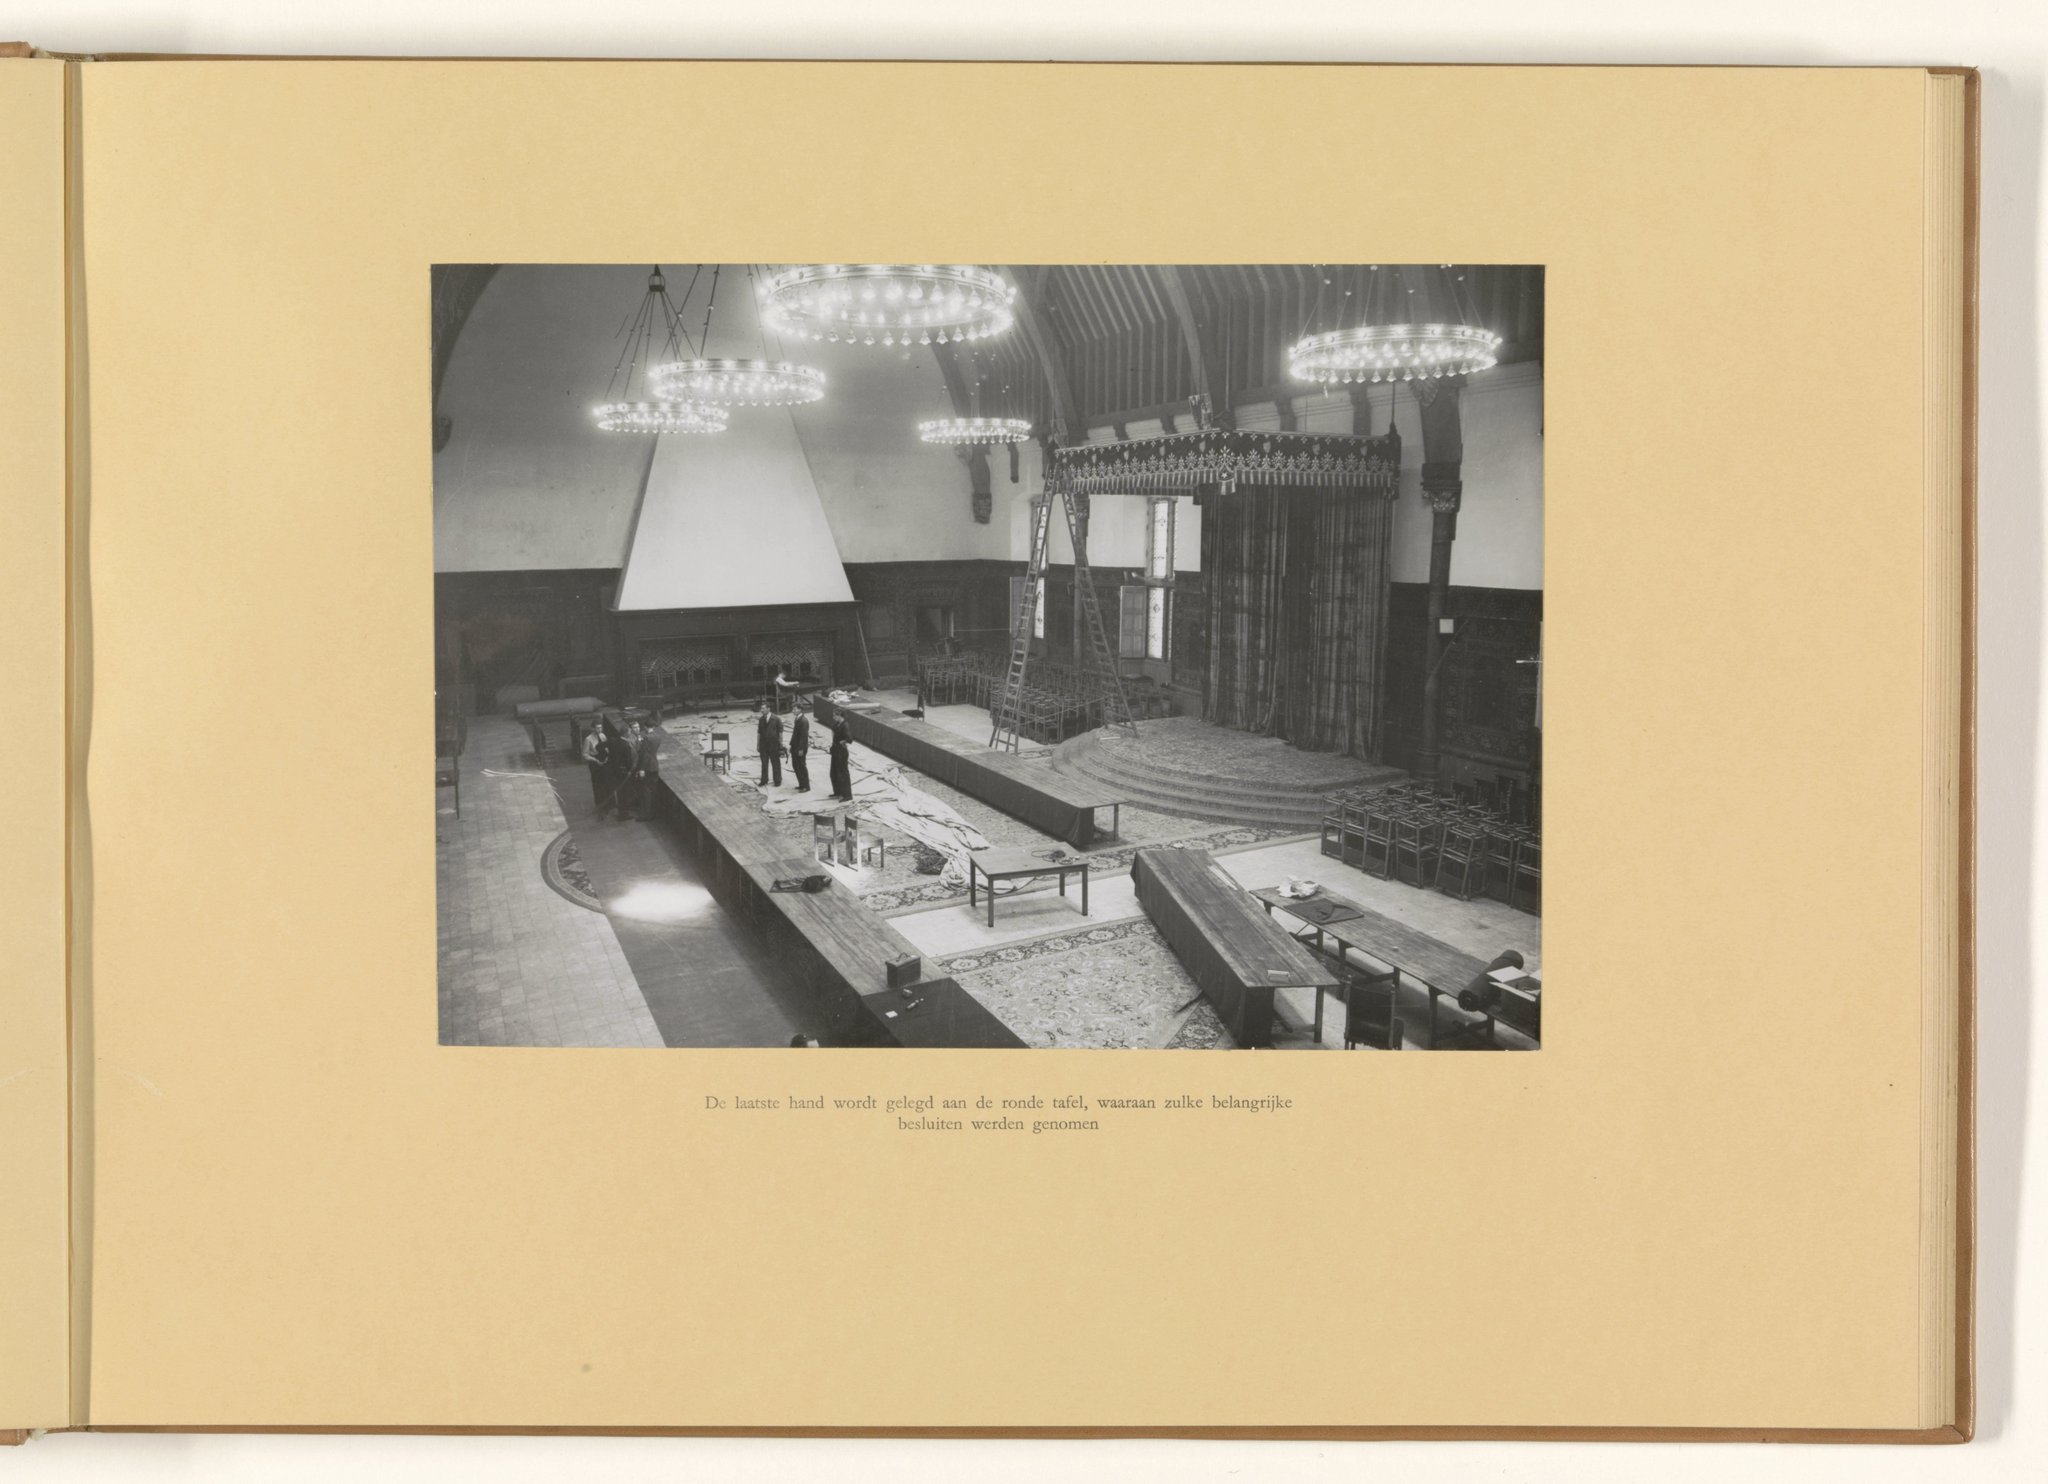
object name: photograph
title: De laatste hand wordt gelegd aan de ronde tafel, waaraan zulke belangrijke besluiten werden genomen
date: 1949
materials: paper, photographic support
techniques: gelatin silver print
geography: the hague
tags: the hague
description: Inrichting van de Ridderzaal voor de conferentie. Foto in het fotoalbum met 37 foto's van de rondetafelconferentie gehouden tussen 23 augustus en 2 november in Den Haag in 1949 tussen vertegenwoordigers van Nederland, de Republiek Indonesië en de Bijeenkomst Federaal Overleg. Het exemplaar aangeboden aan premier Willem Drees.